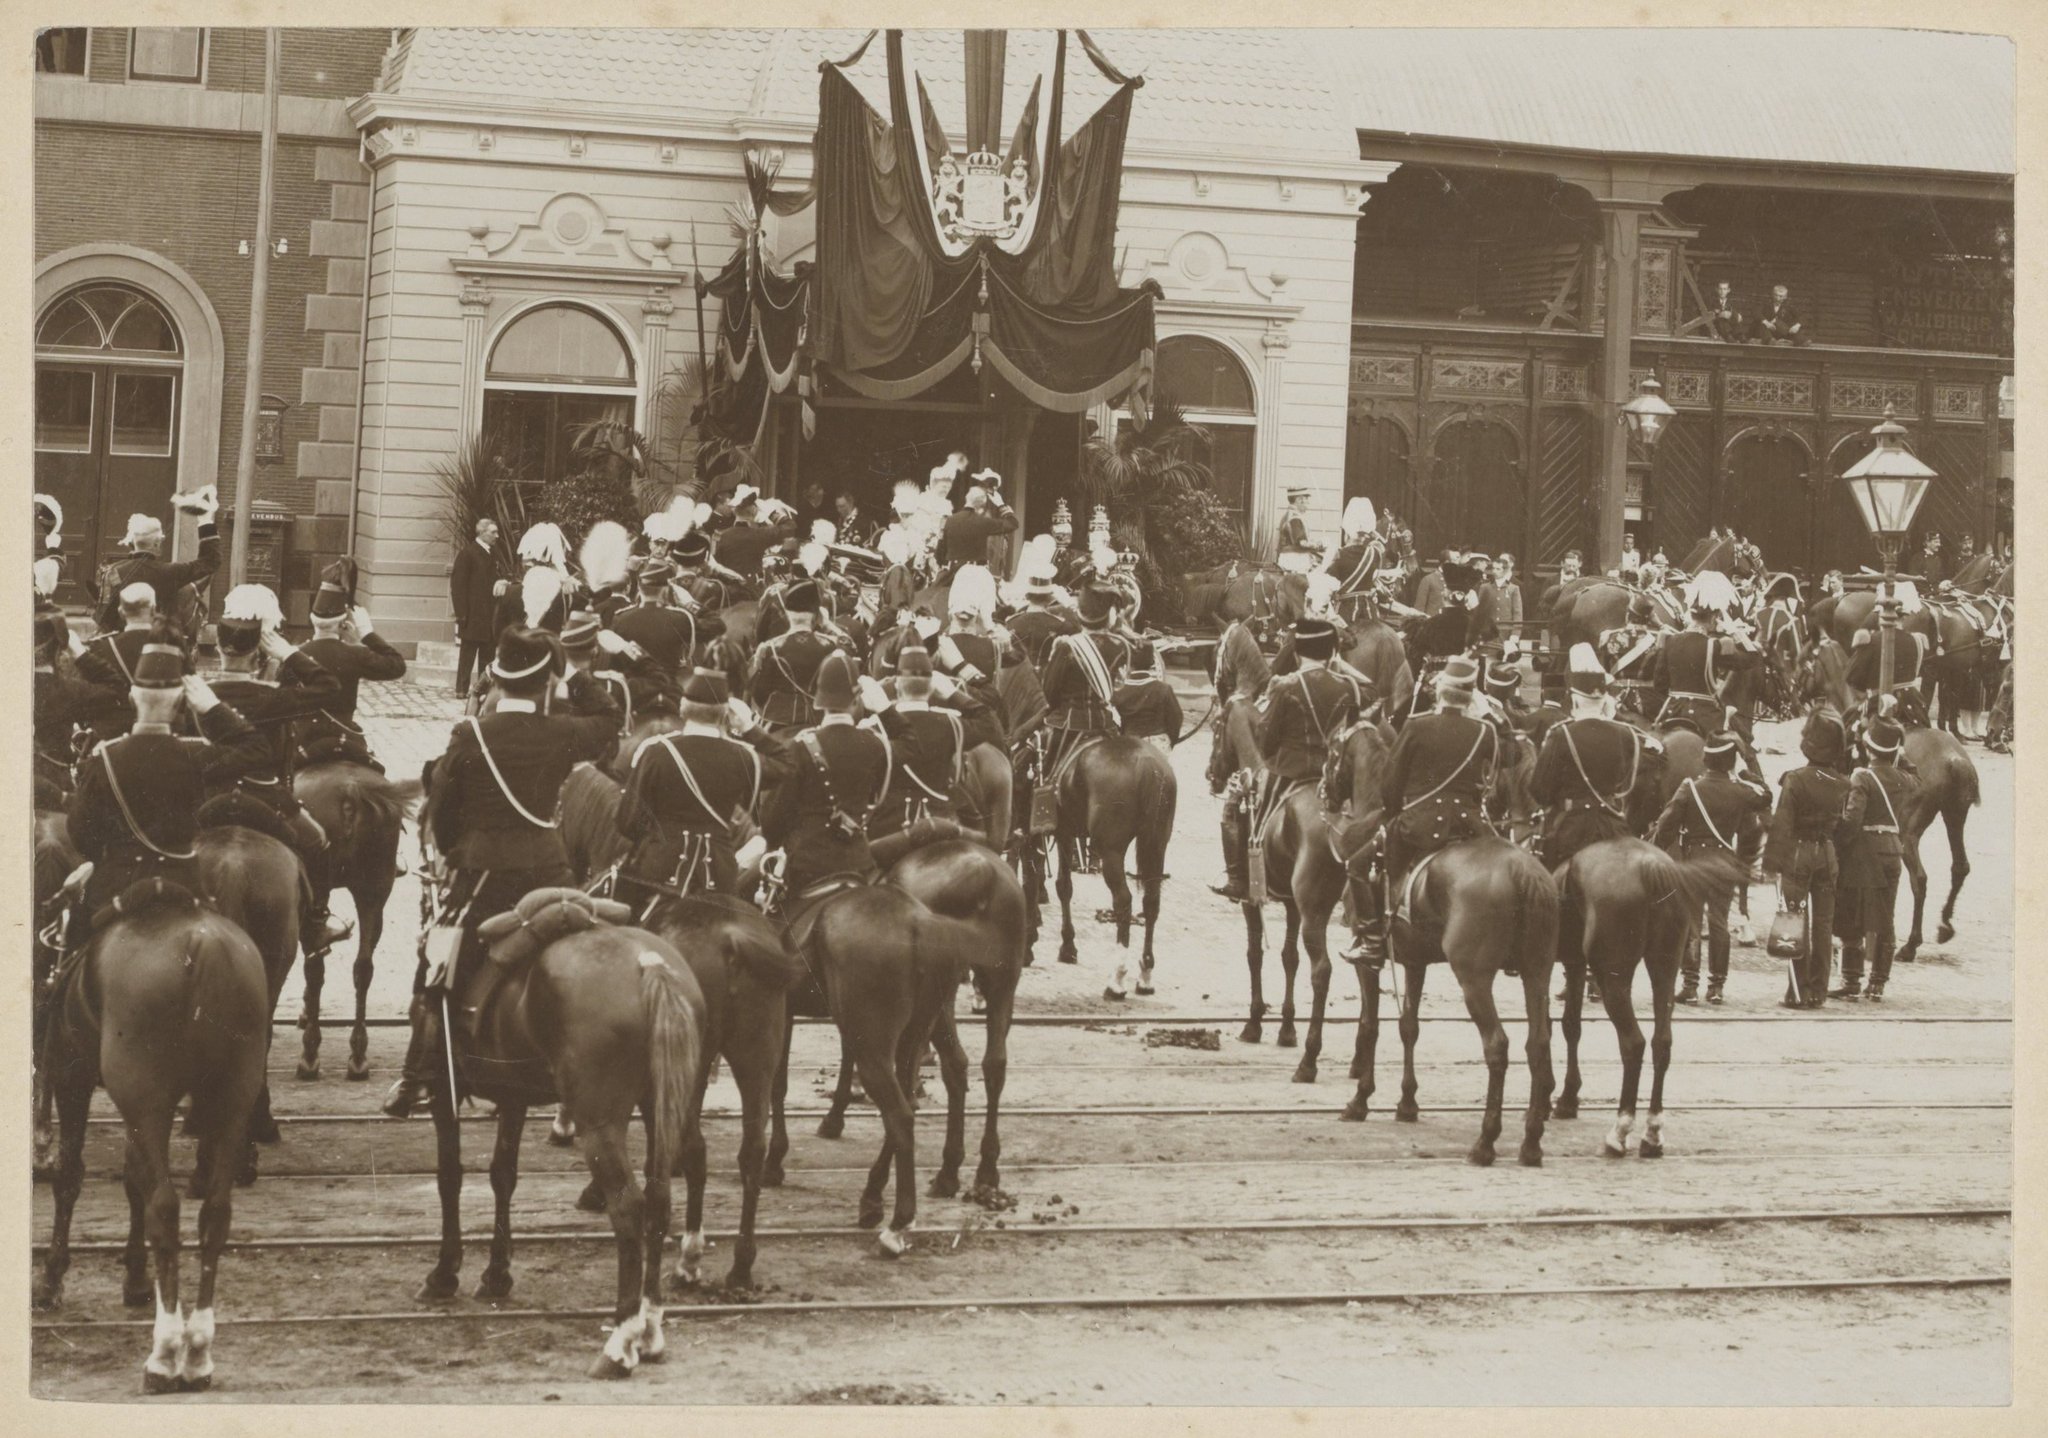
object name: photograph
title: Ontvangst van Koningin Wilhelmina en Koningin-Moeder Emma op het Weesperpleinstation te Amsterdam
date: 1809-1898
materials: cardboard, paper, photographic support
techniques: collodion silver print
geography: weesperpoortstation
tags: wilhelmina of the netherlands, the hague, emma (queen consort of the netherlands), politician, riding a horse, ass, or mule; rider, horseman, ceremonial celebration of installation of a ruler, public festivities on the occasion of royal events, installation of a ruler - bb - female ruler, mayor, burgomaster, station; shelter (railway, tramway)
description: Koningin-moeder Emma en Koningin Wilhelmina worden feestelijk ingehaald bij aankomst op het Weesperpoortstation. De Amsterdamse burgemeester S.A. Vening Meinesz begroet hen onder de versierde stationsingang, terwijl een escorte van ruiters toekijkt. Onderdeel van Fotoalbum met 11 opnames van de inhuldiging van Koningin Wilhelmina en de inhuldigingsfeesten.